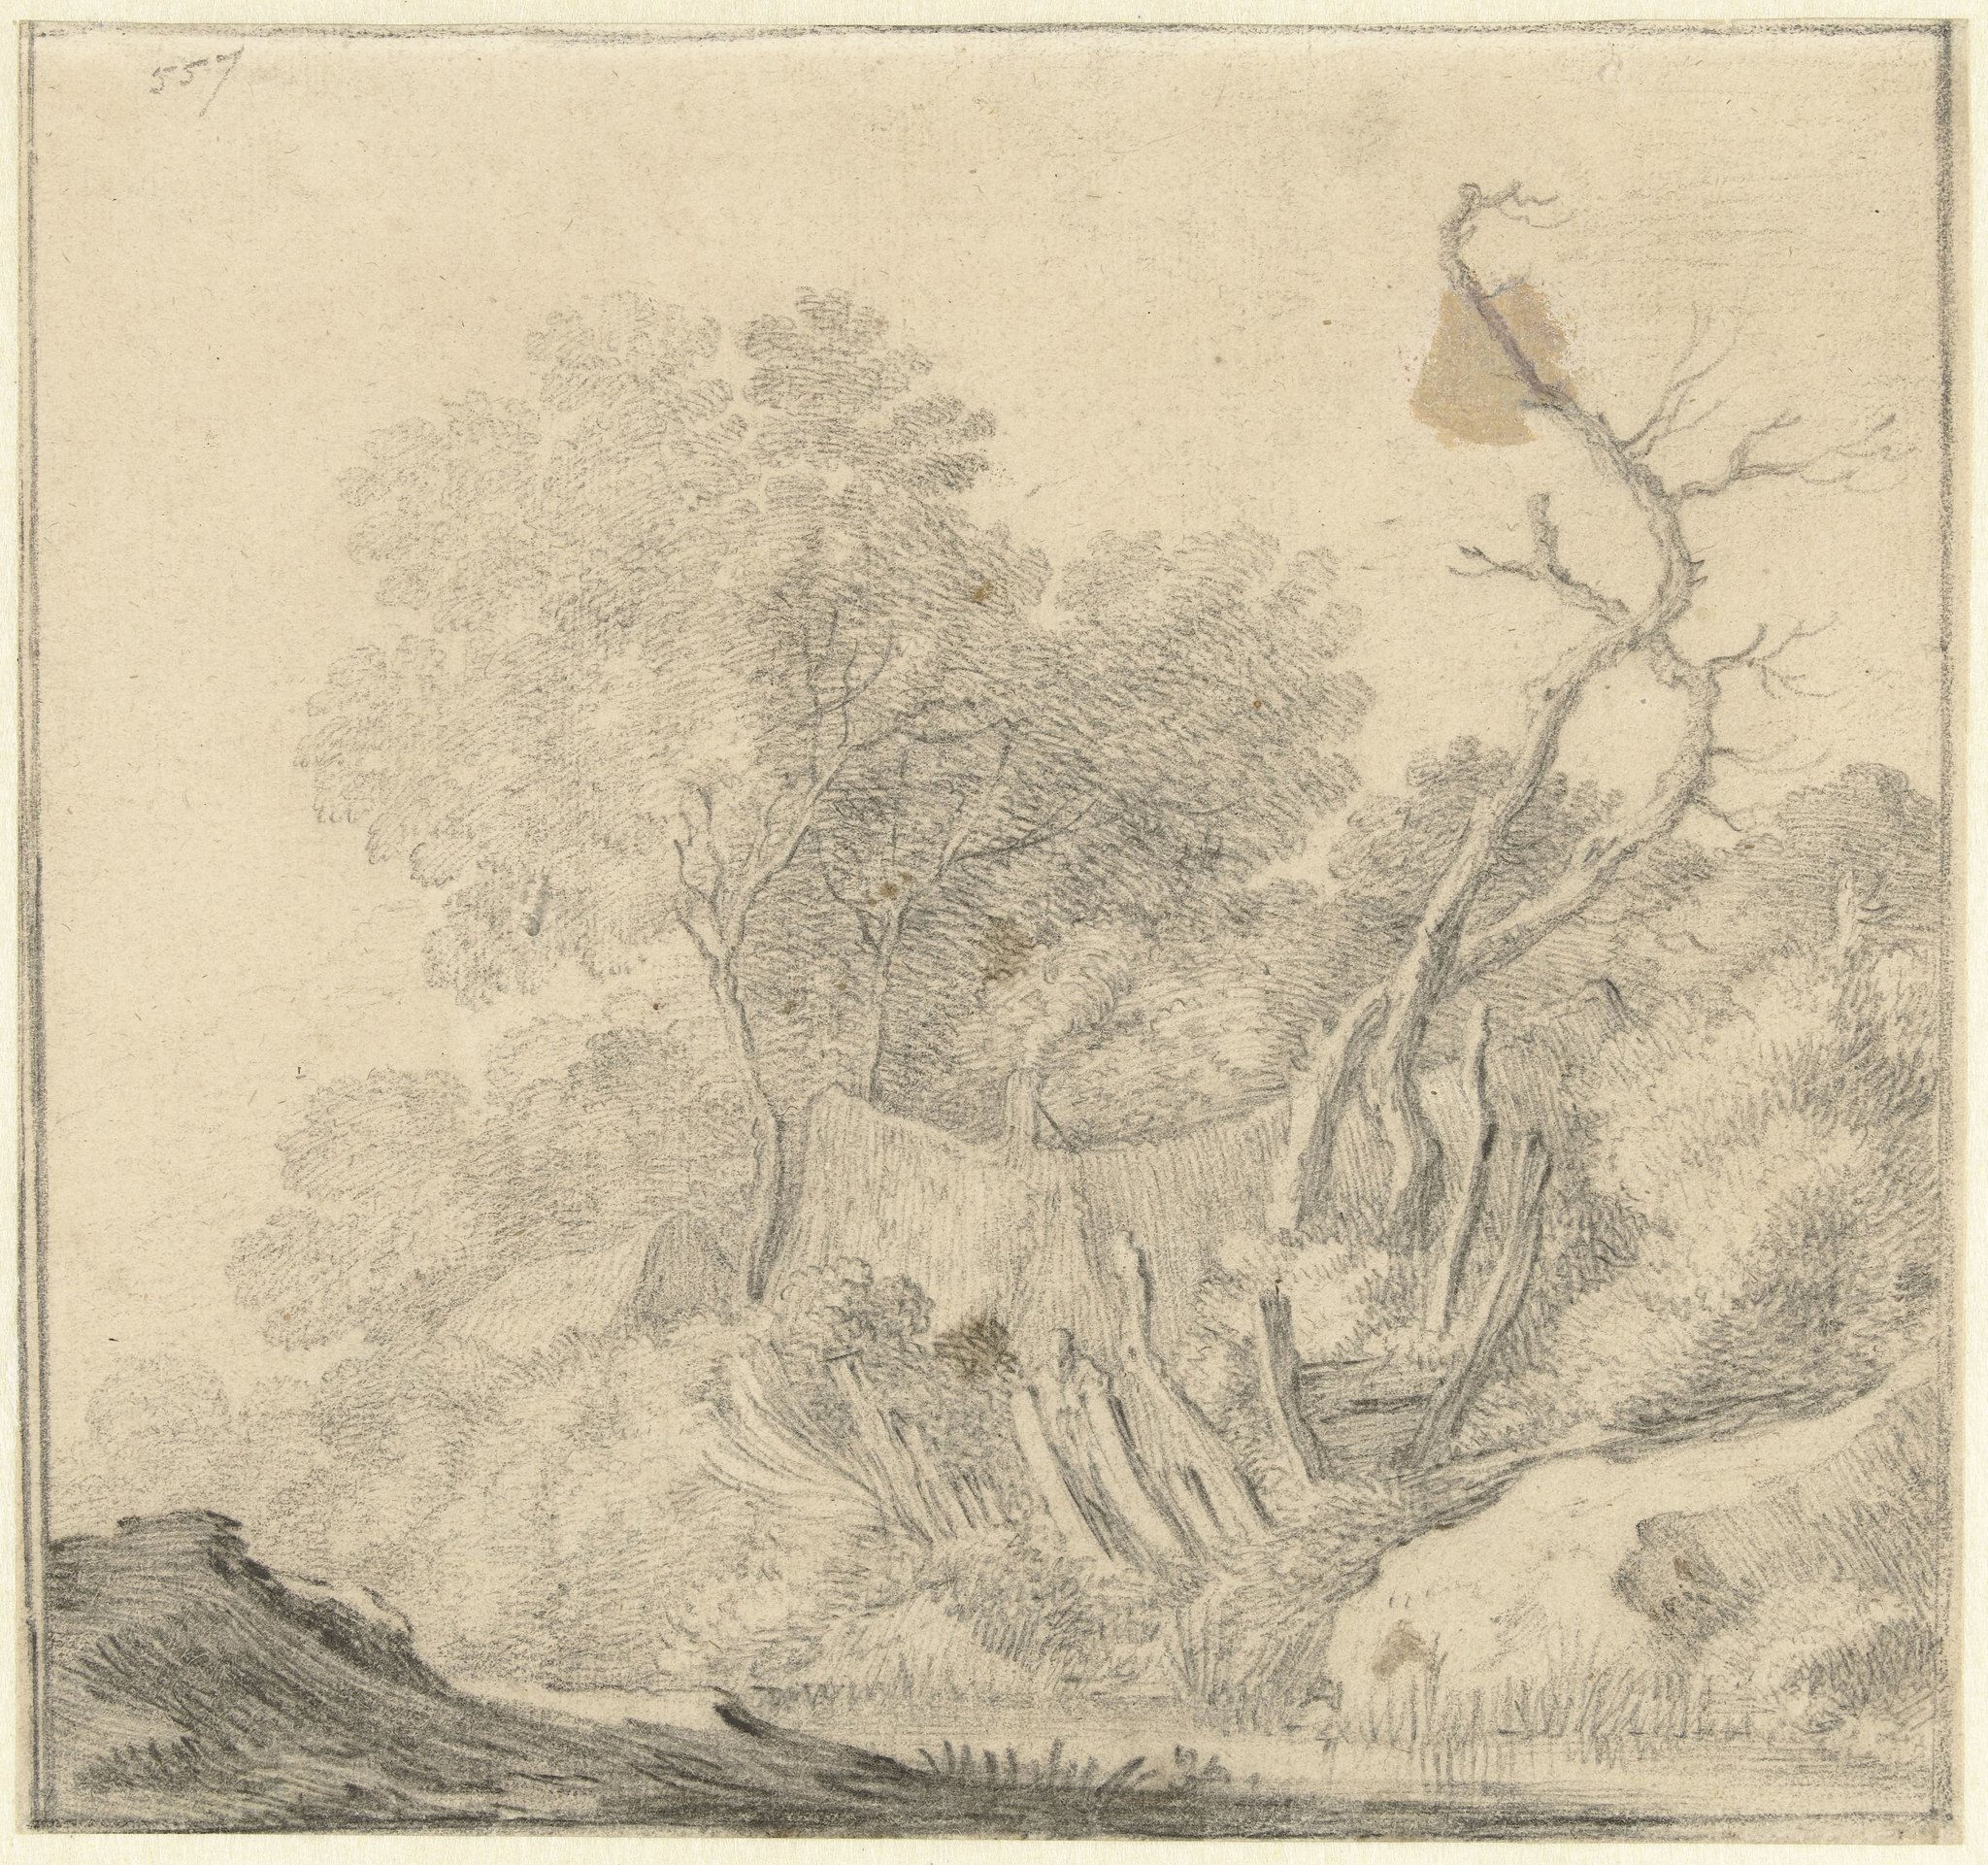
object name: drawing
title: Huizen tussen bomen bij water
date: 1630-1636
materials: chalk, paper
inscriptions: annotation: ‘P. Molyn’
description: Aanvankelijk toegeschreven aan Pieter Molijn, vanwege de annotatie en de stijl, maar waarschijnlijk door Gerard (II) gemaakt op de manier van zijn leermeester Molijn (in de stijl van de Haarlemse periode evenals de tekeningen GJr 43-51), of door een andere navolger van Molijn.